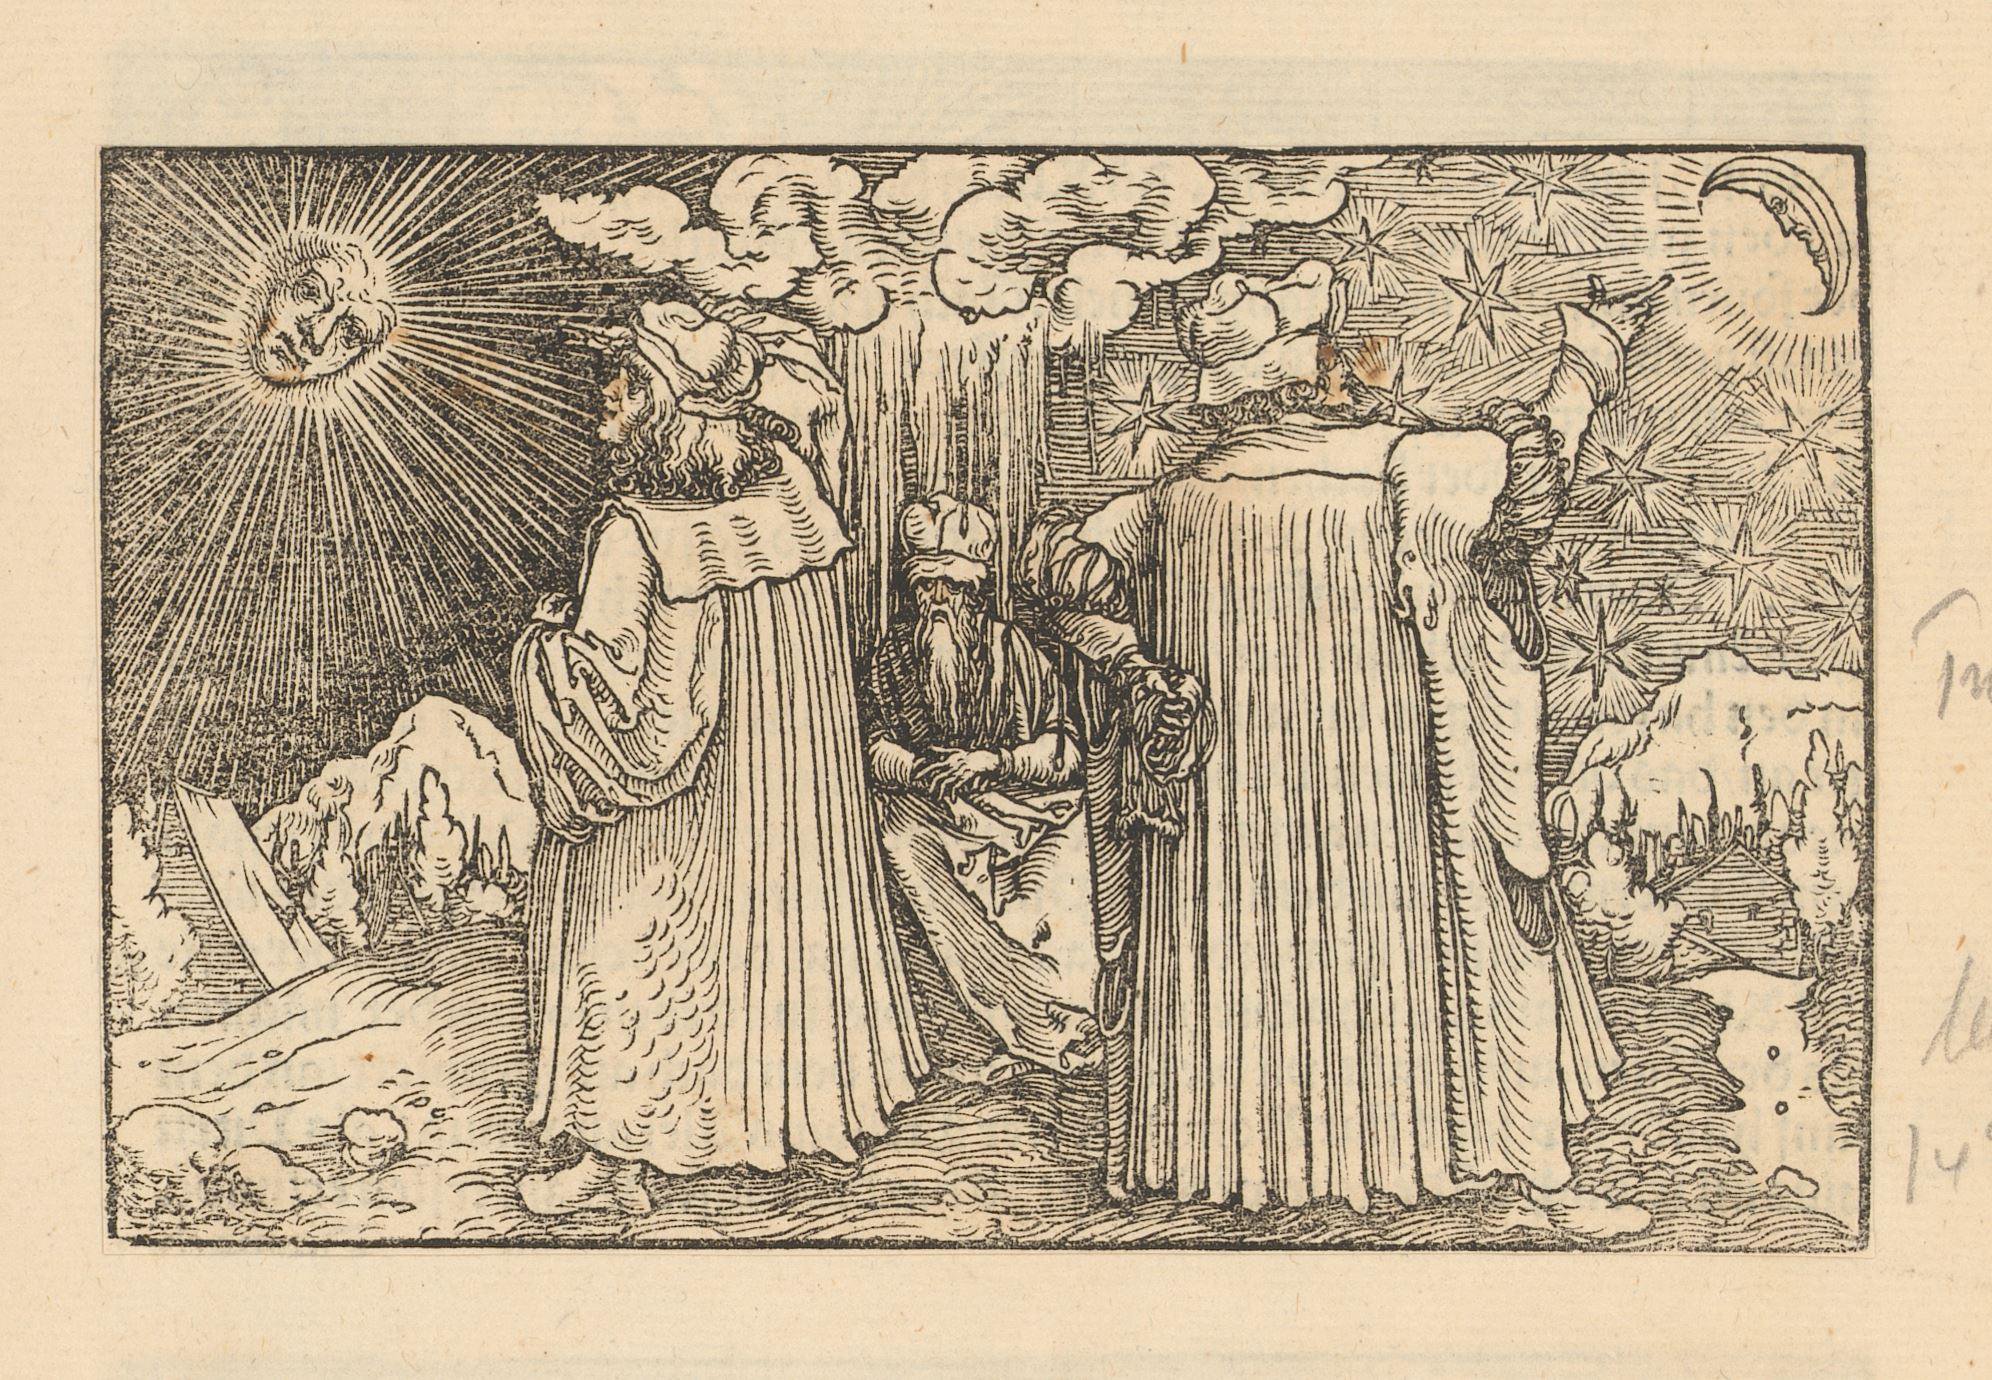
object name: album leaf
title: Twee mannen bestuderen de zon en de maan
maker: Anonymous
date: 1514-1532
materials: paper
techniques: letterpress printing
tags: contemplating the firmament, astrologer observing the heavens, contemplation of the moon, 'schwärmen', the heavens (celestial bodies)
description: Deze prent is gebruikt in: Petrarca, Francesco. Von der Artzney bayder Glück, des guten und widerwertigen: unnd weß sich ain yeder inn Gelück und Unglück halten sol (...). Augsburg: Heinrich Steiner, 1532. Deze uitgave is ook bekend onder de titel 'Trostspiegel in Glück und Unglück'.